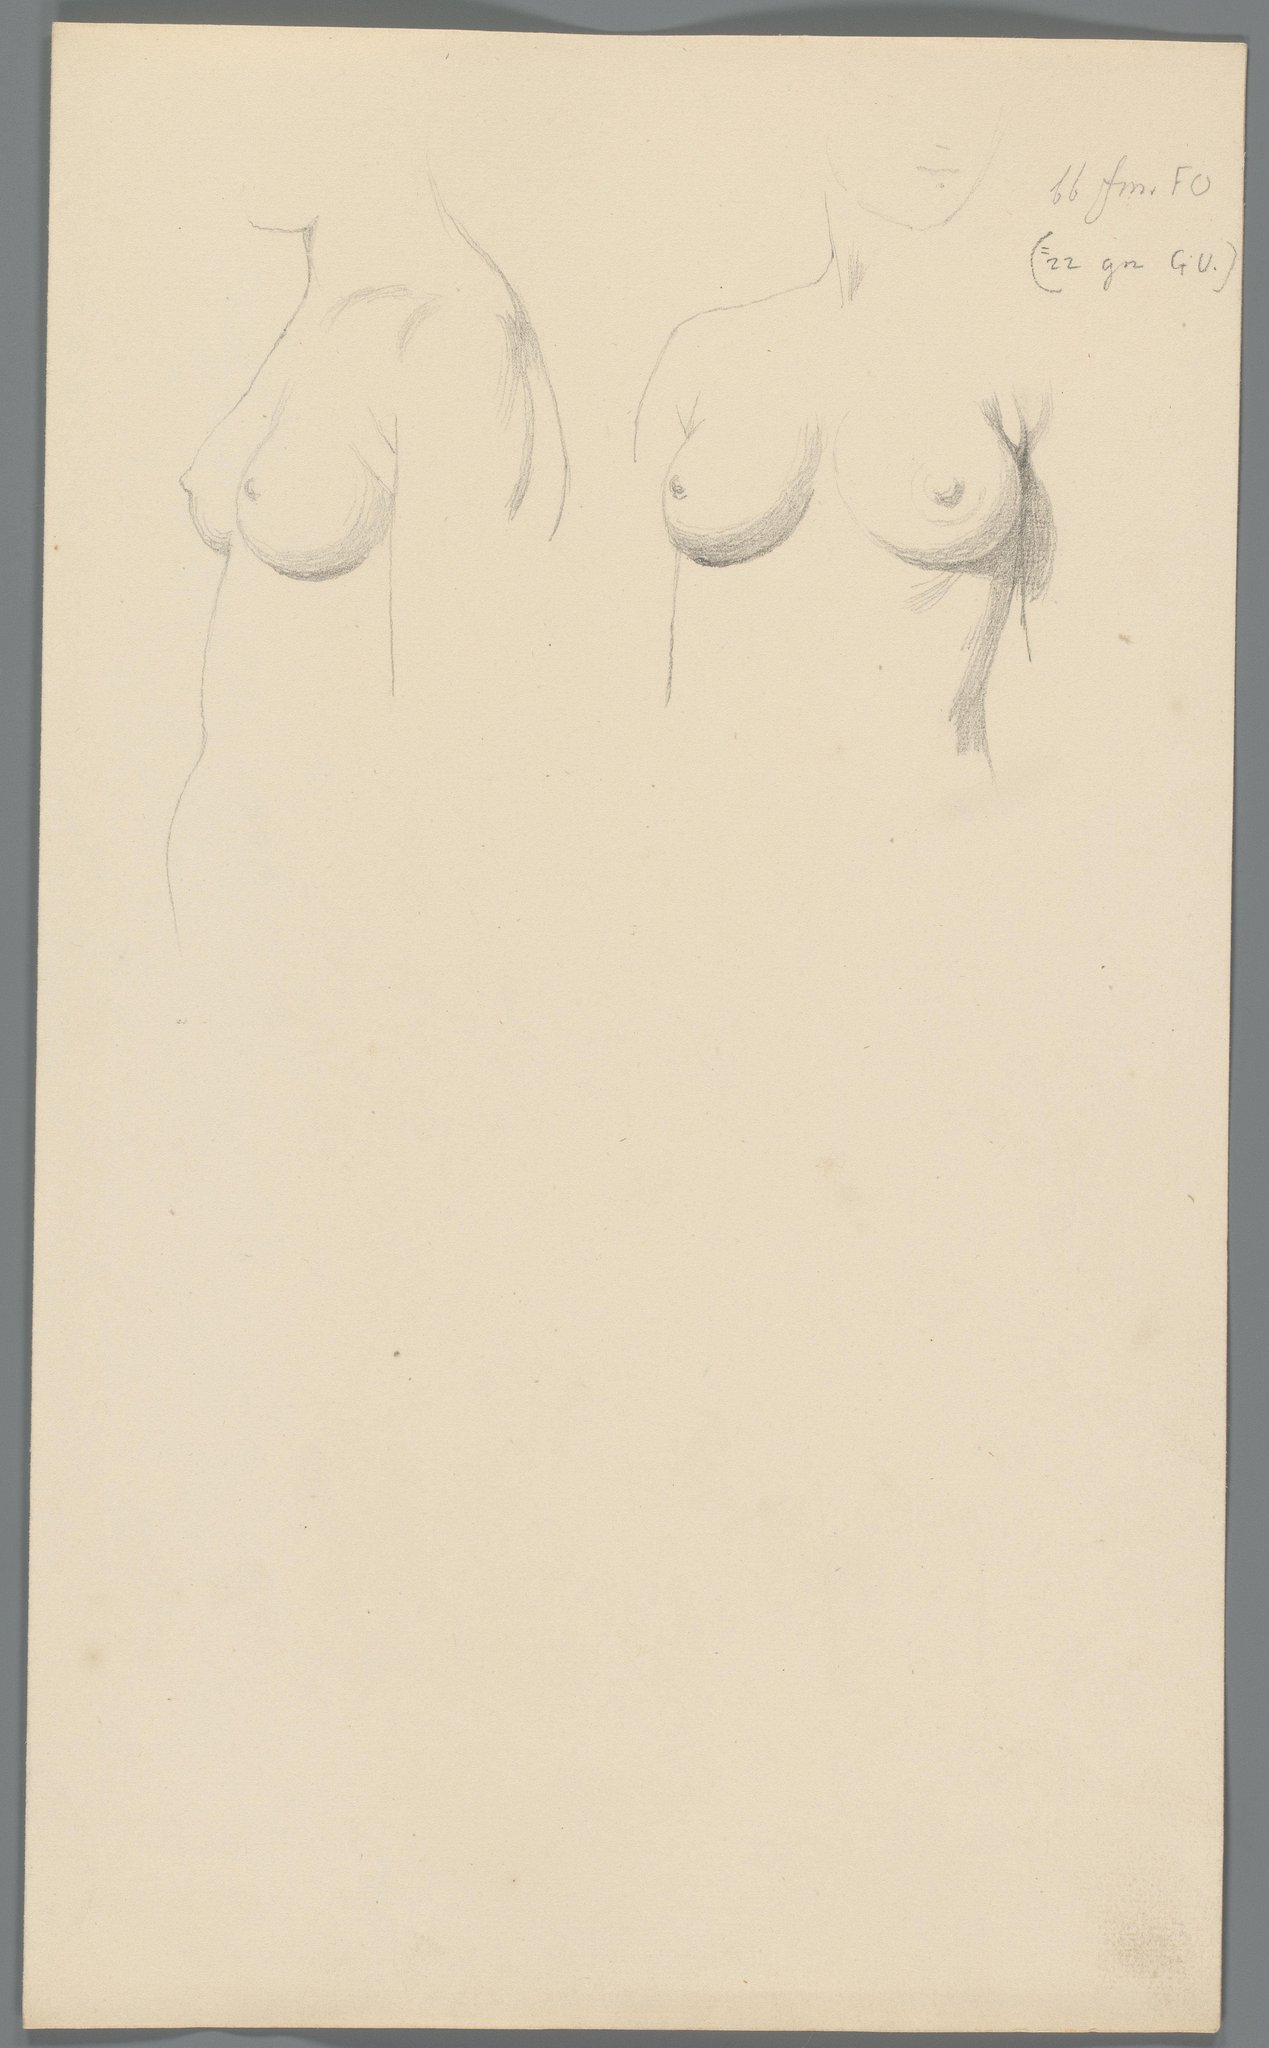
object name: drawing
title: Studie van borsten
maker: jacobus everhardus josephus van den berg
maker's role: draughtsman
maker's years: 1802-1861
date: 1812-1861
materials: paper, pencil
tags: breasts - aa - female human figure